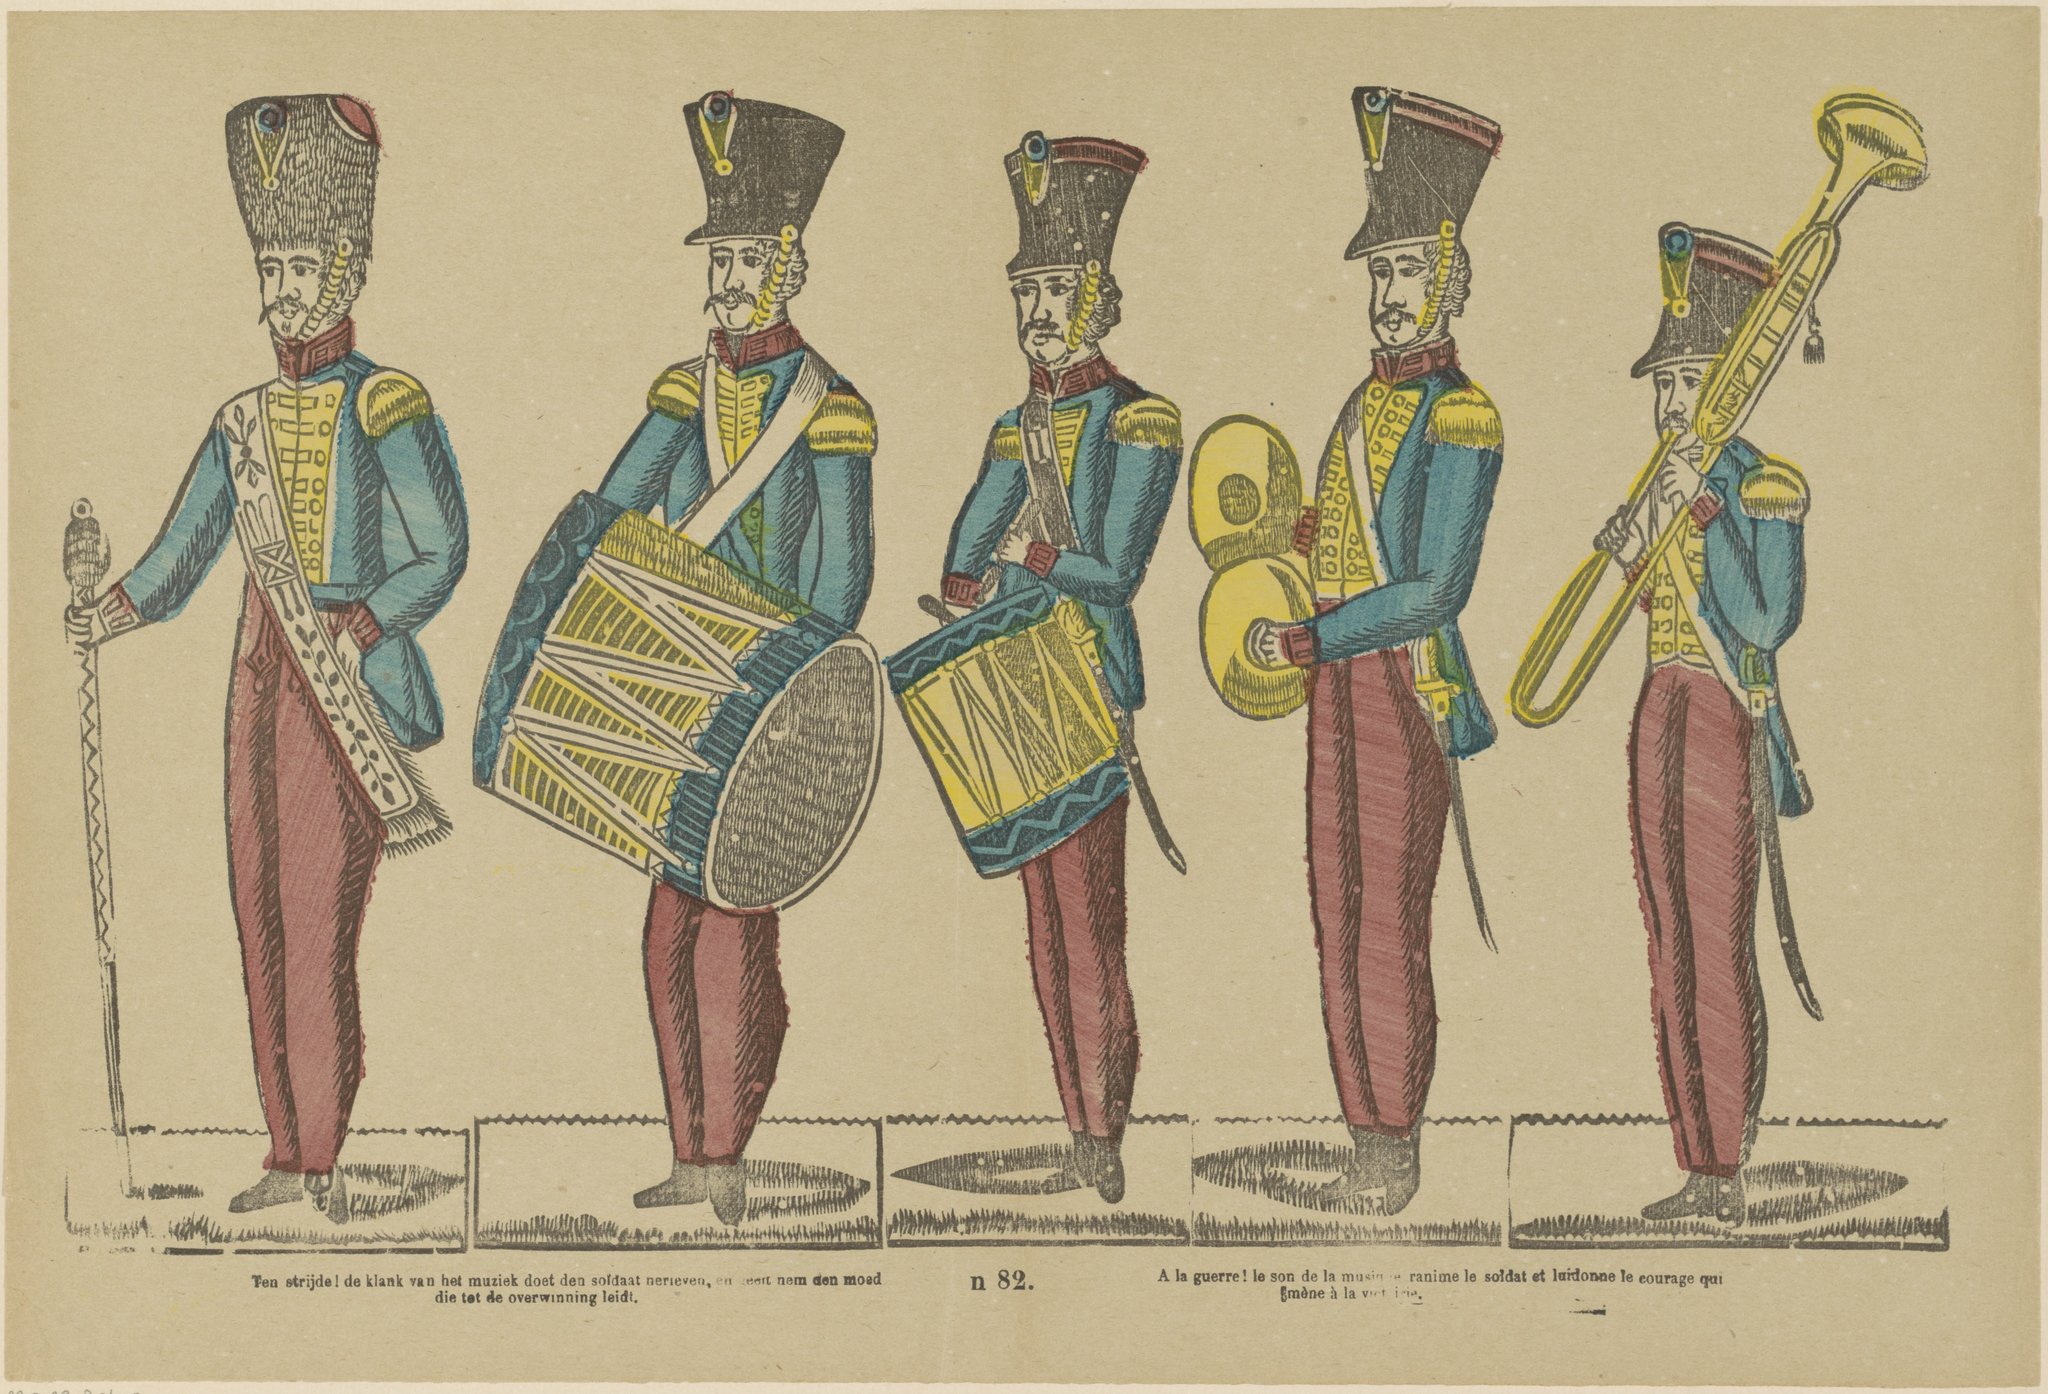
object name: print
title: Militaire band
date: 1866-1902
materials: paper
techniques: colour, letterpress printing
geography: turnhout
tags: military band, the soldier; the soldier's life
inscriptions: collector's mark: Lugt 2760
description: Blad met 5 staande militairen met muziekinstrumenten. Figuren om uit te knippen, op karton te plakken en aan de voet te verstevigen met een klosje hout om ze overeind te kunnen zetten. Onder de voorstellingen een tweeregelig onderschrift in het Nederlands en in het Frans. Genummerd midden onder: n 82.